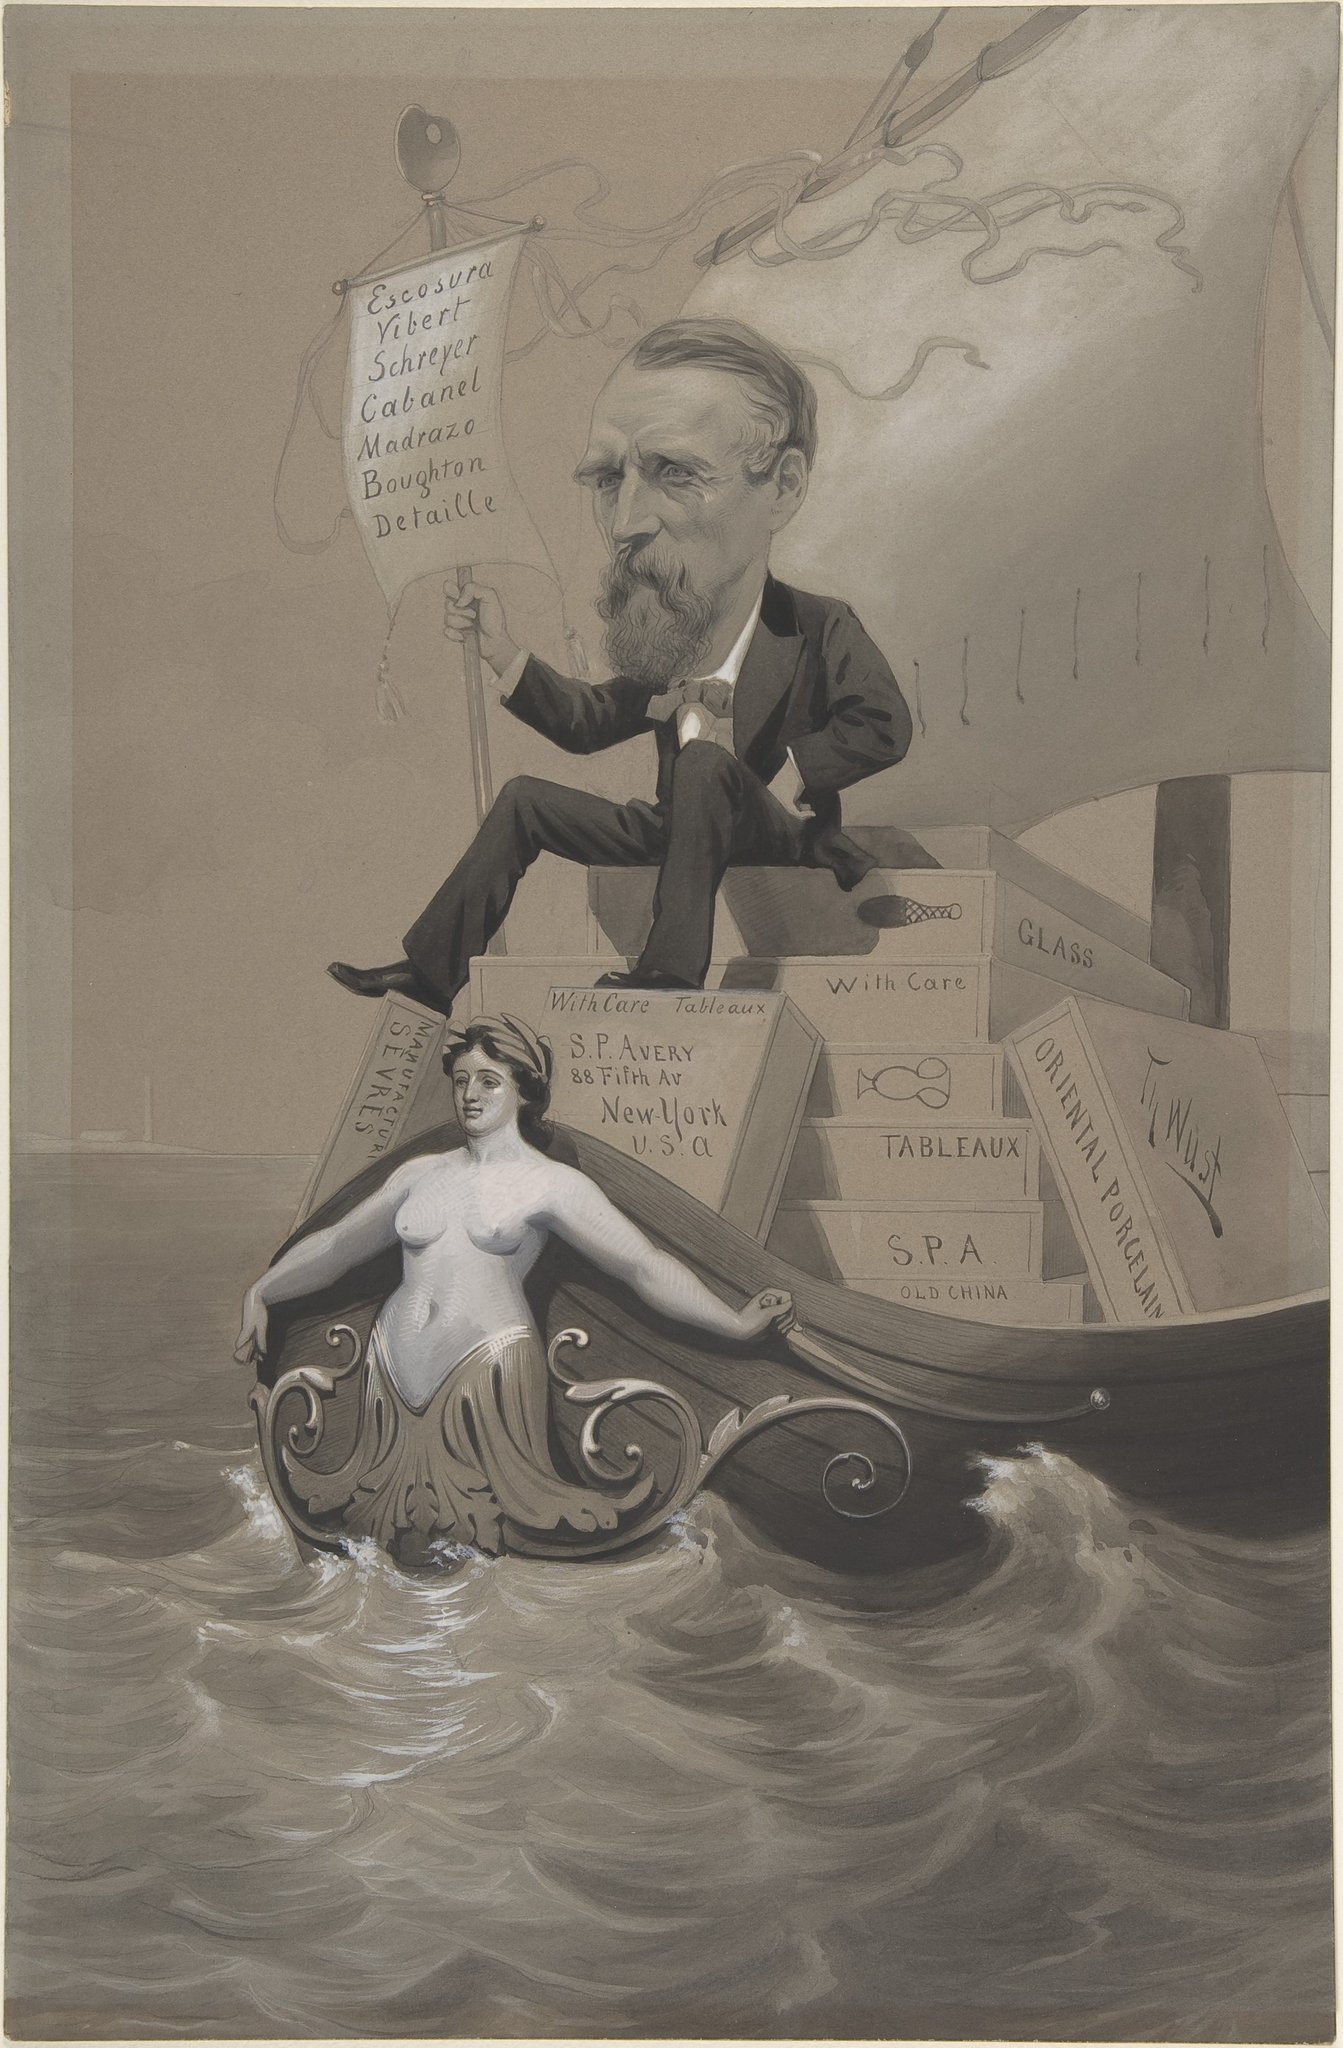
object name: drawing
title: Samuel P. Avery Transporting His Treasures Across the Sea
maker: theodore wust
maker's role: artist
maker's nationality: american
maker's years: 1853-1915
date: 1875-1880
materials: gouache, graphite, ink, paper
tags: men,boats,caricature